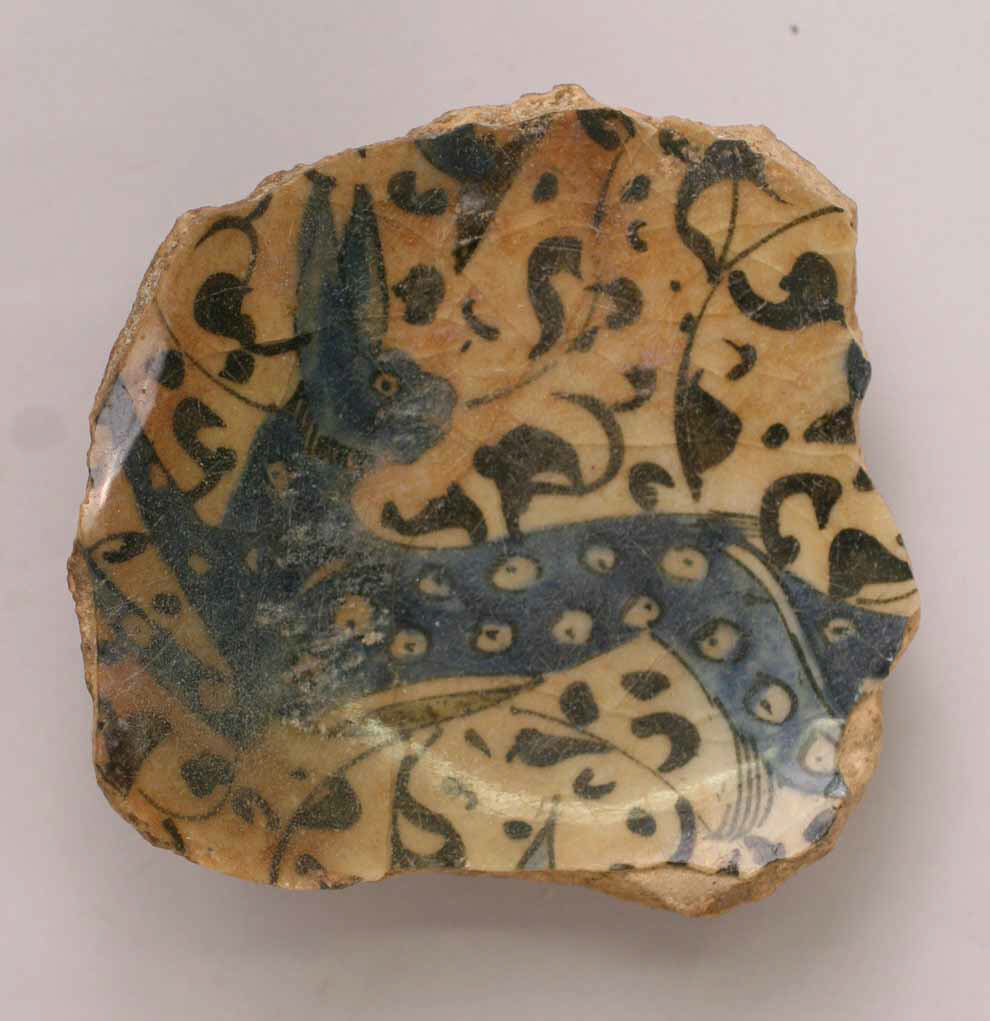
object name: fragment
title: Ceramic Fragment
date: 1201-1600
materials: glaze, stonepaste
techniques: painting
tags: animals